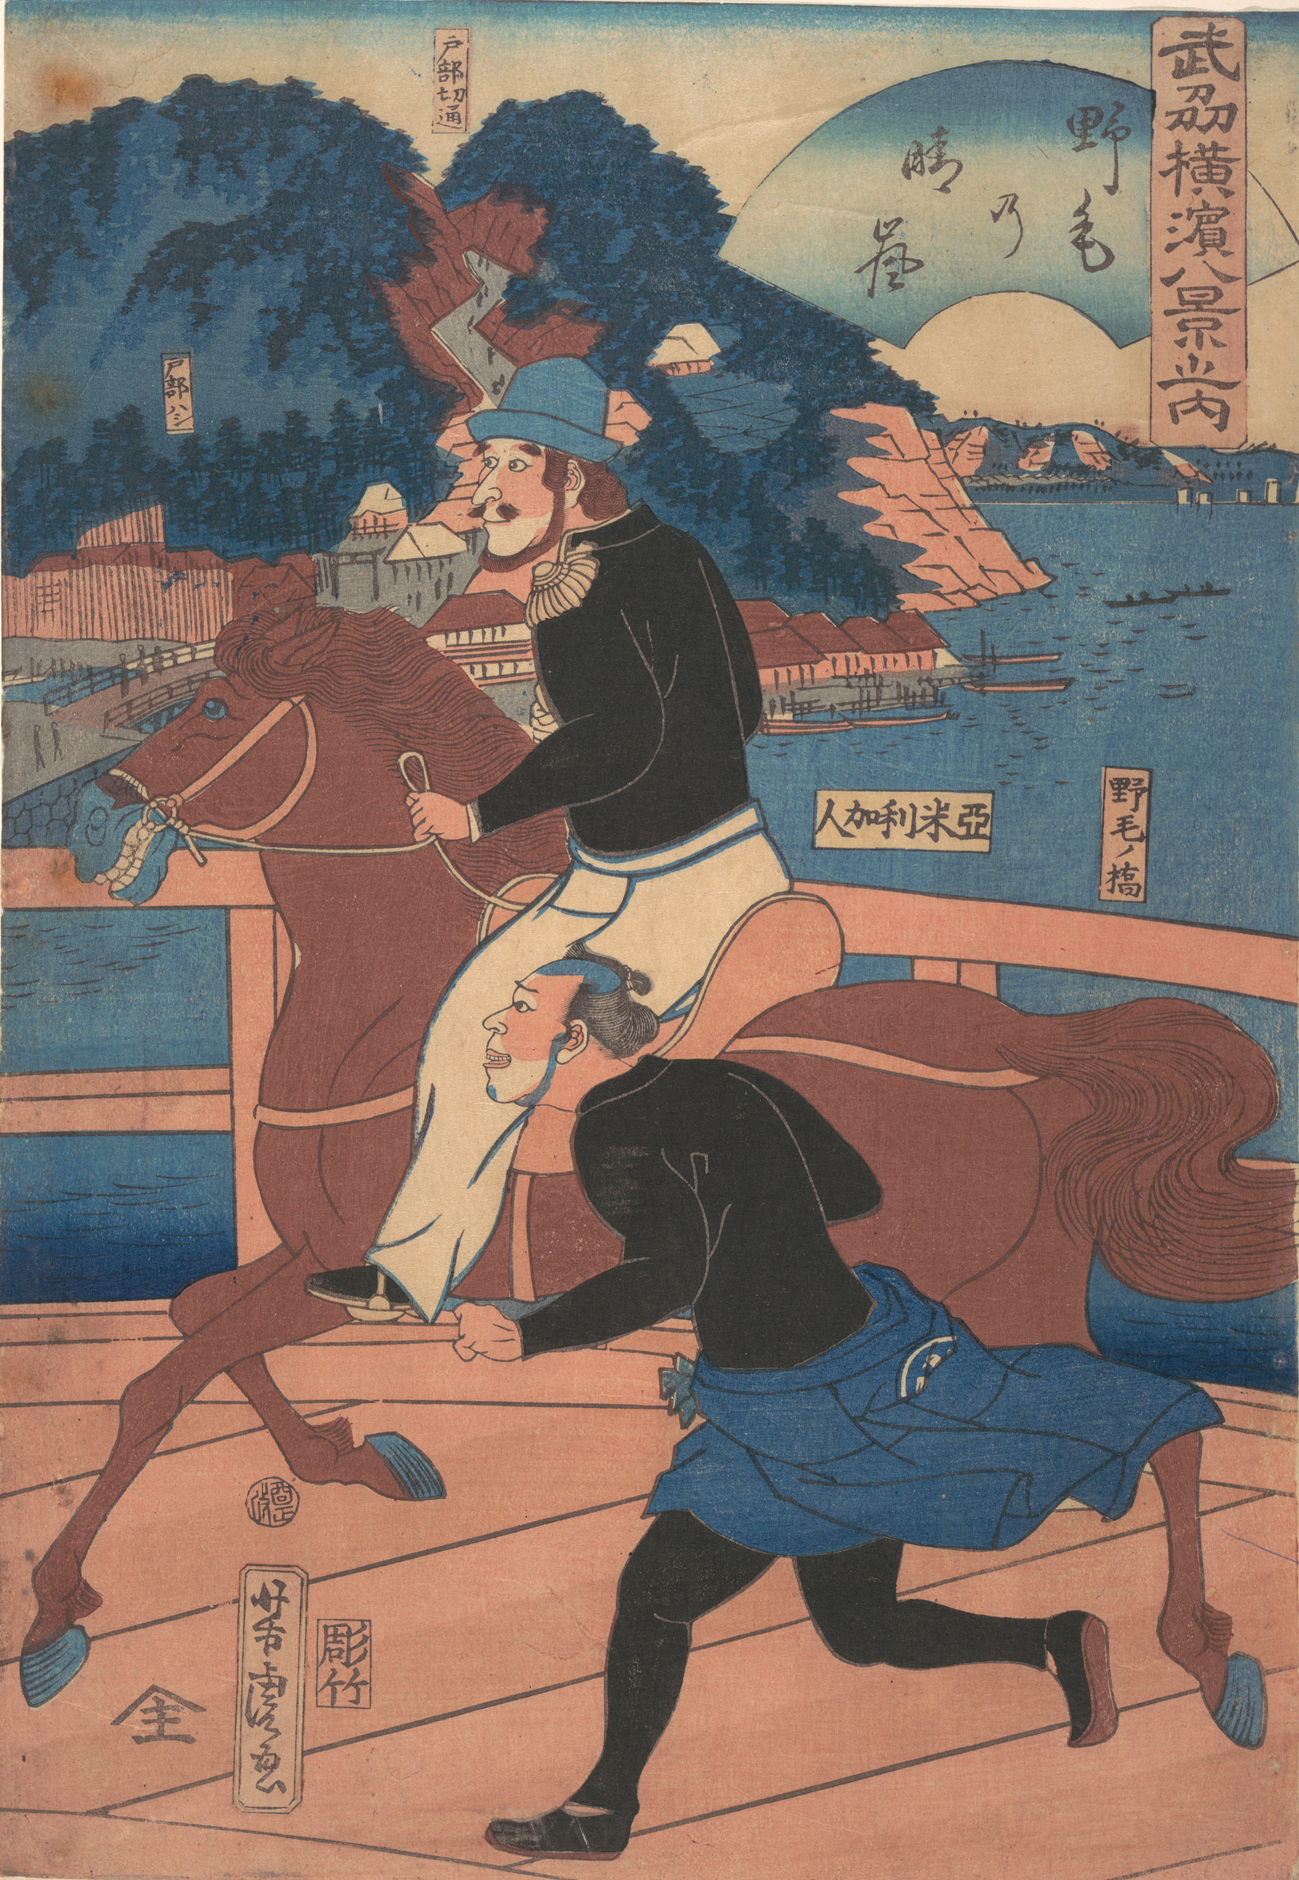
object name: print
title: Returning Sails at Nōgei [American couple riding over the Nōgei Bridge]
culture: japanese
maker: utagawa yoshitora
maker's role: artist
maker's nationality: japanese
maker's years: 1845-1880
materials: ink, paper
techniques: woodblock print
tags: bridges,men,horses